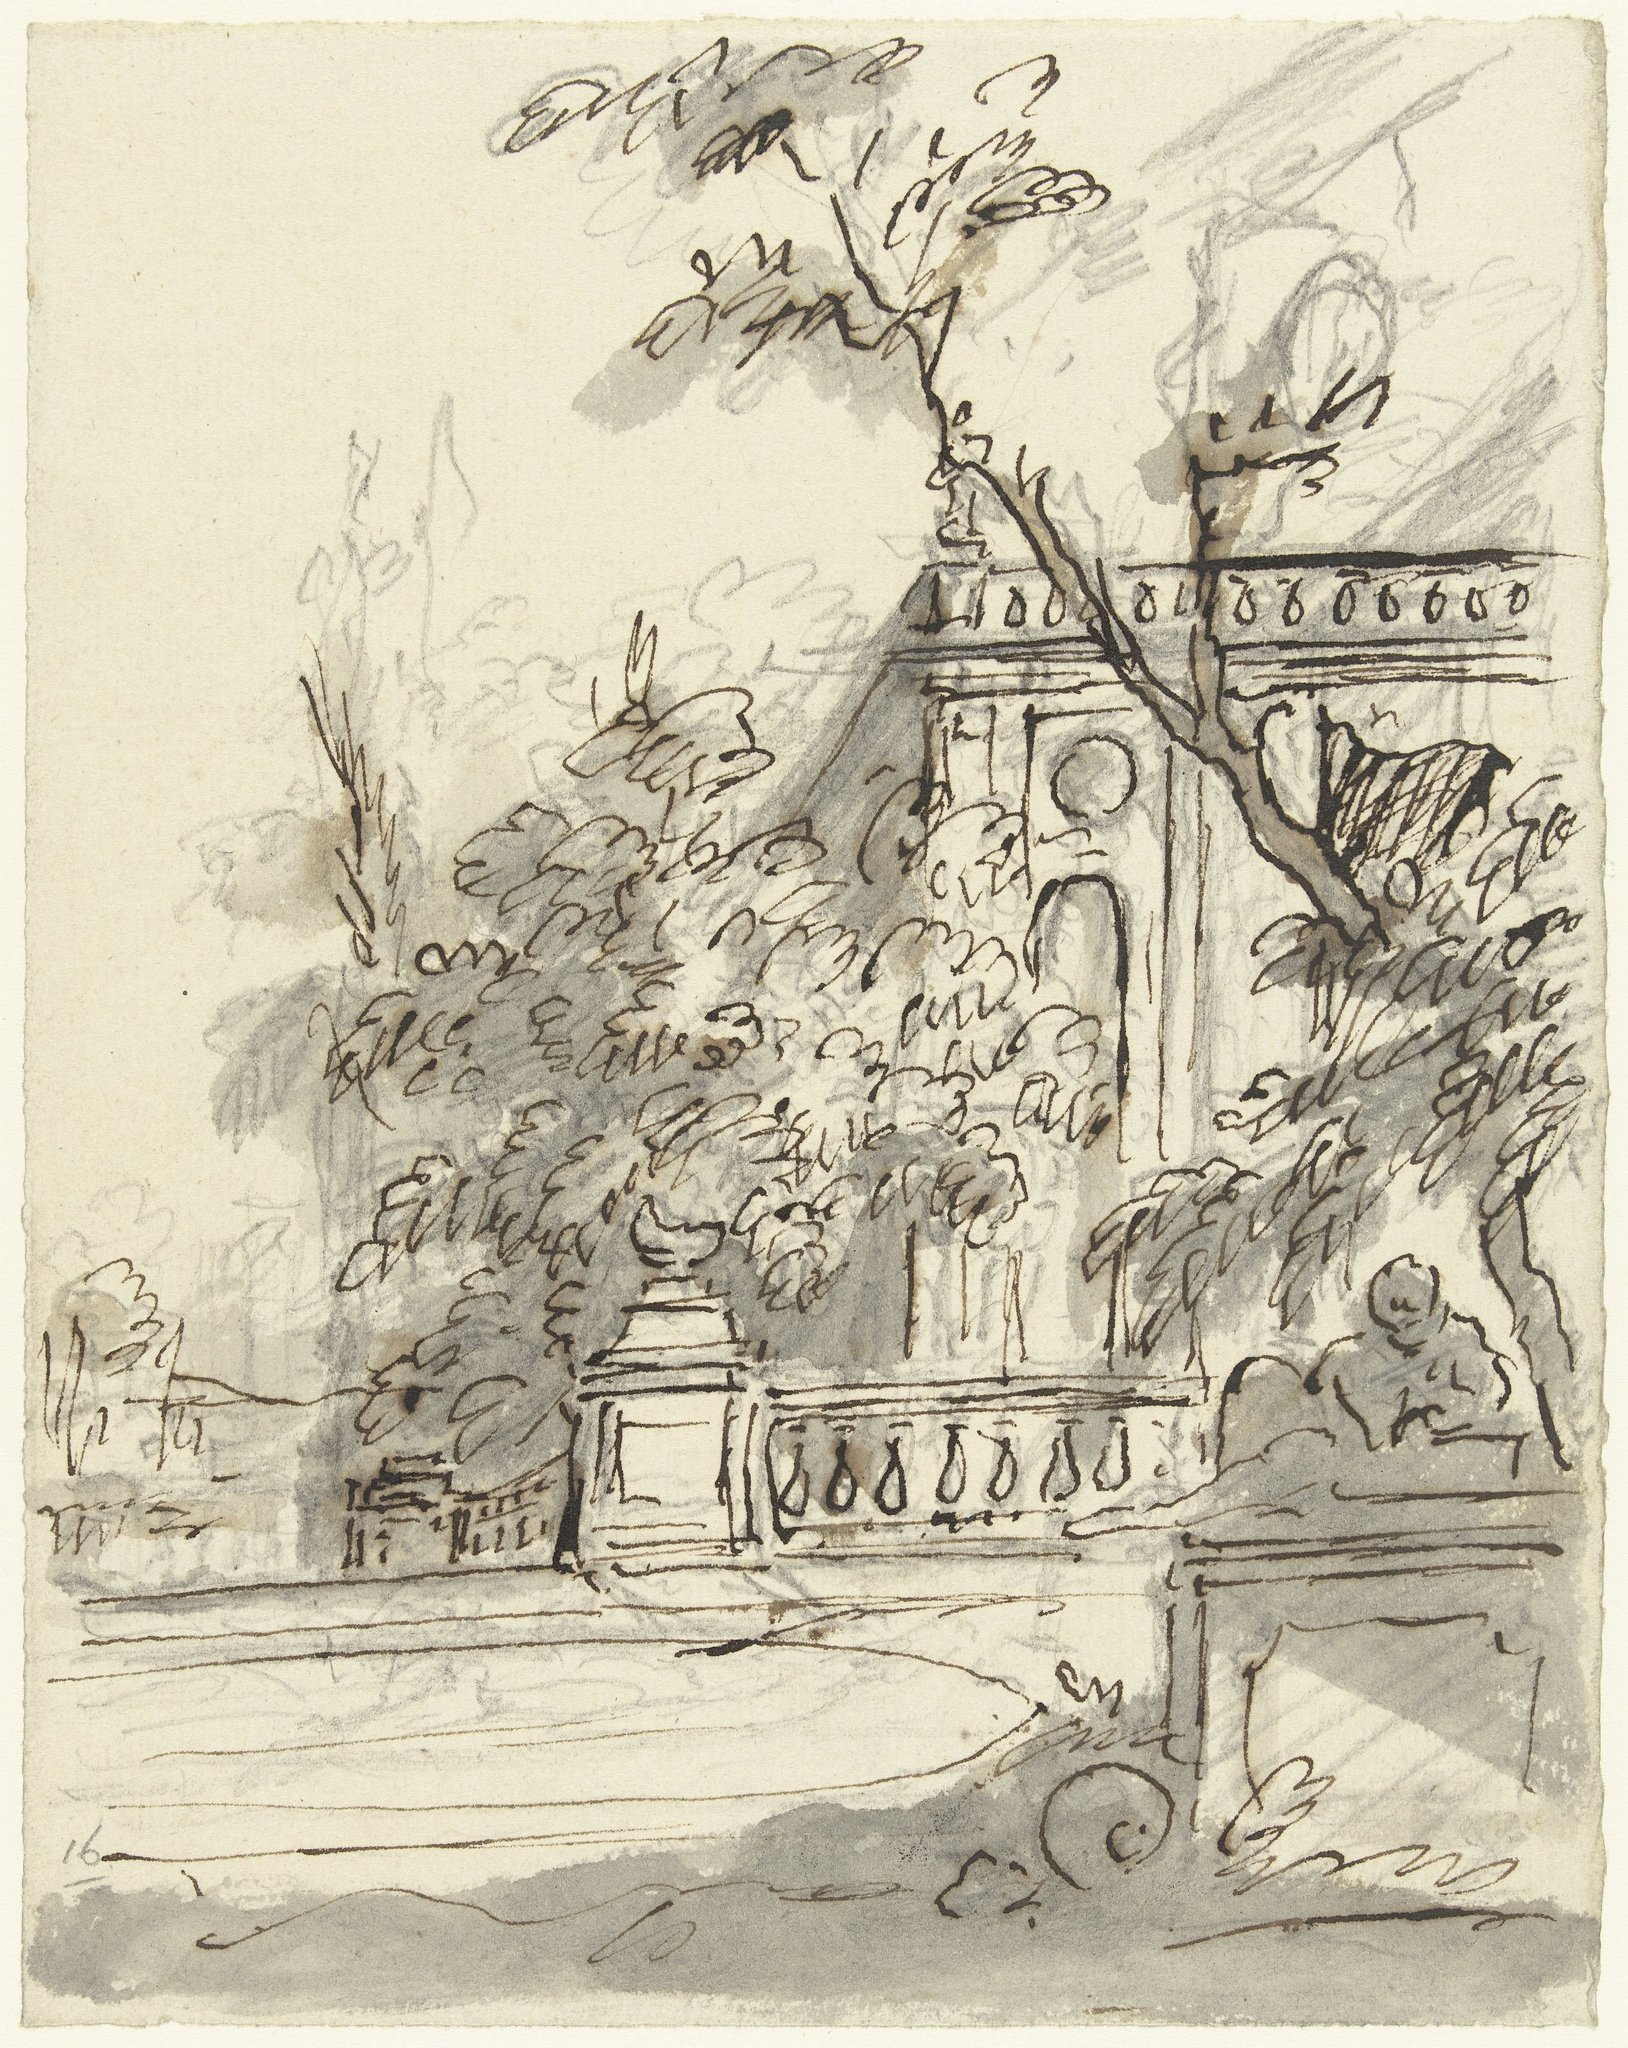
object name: drawing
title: Tuingezicht met vijver en balustrade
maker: dionys van nijmegen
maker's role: draughtsman, painter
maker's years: 1705-1798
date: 1715-1798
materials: ink, paper, pencil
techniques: brush, pen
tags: garden